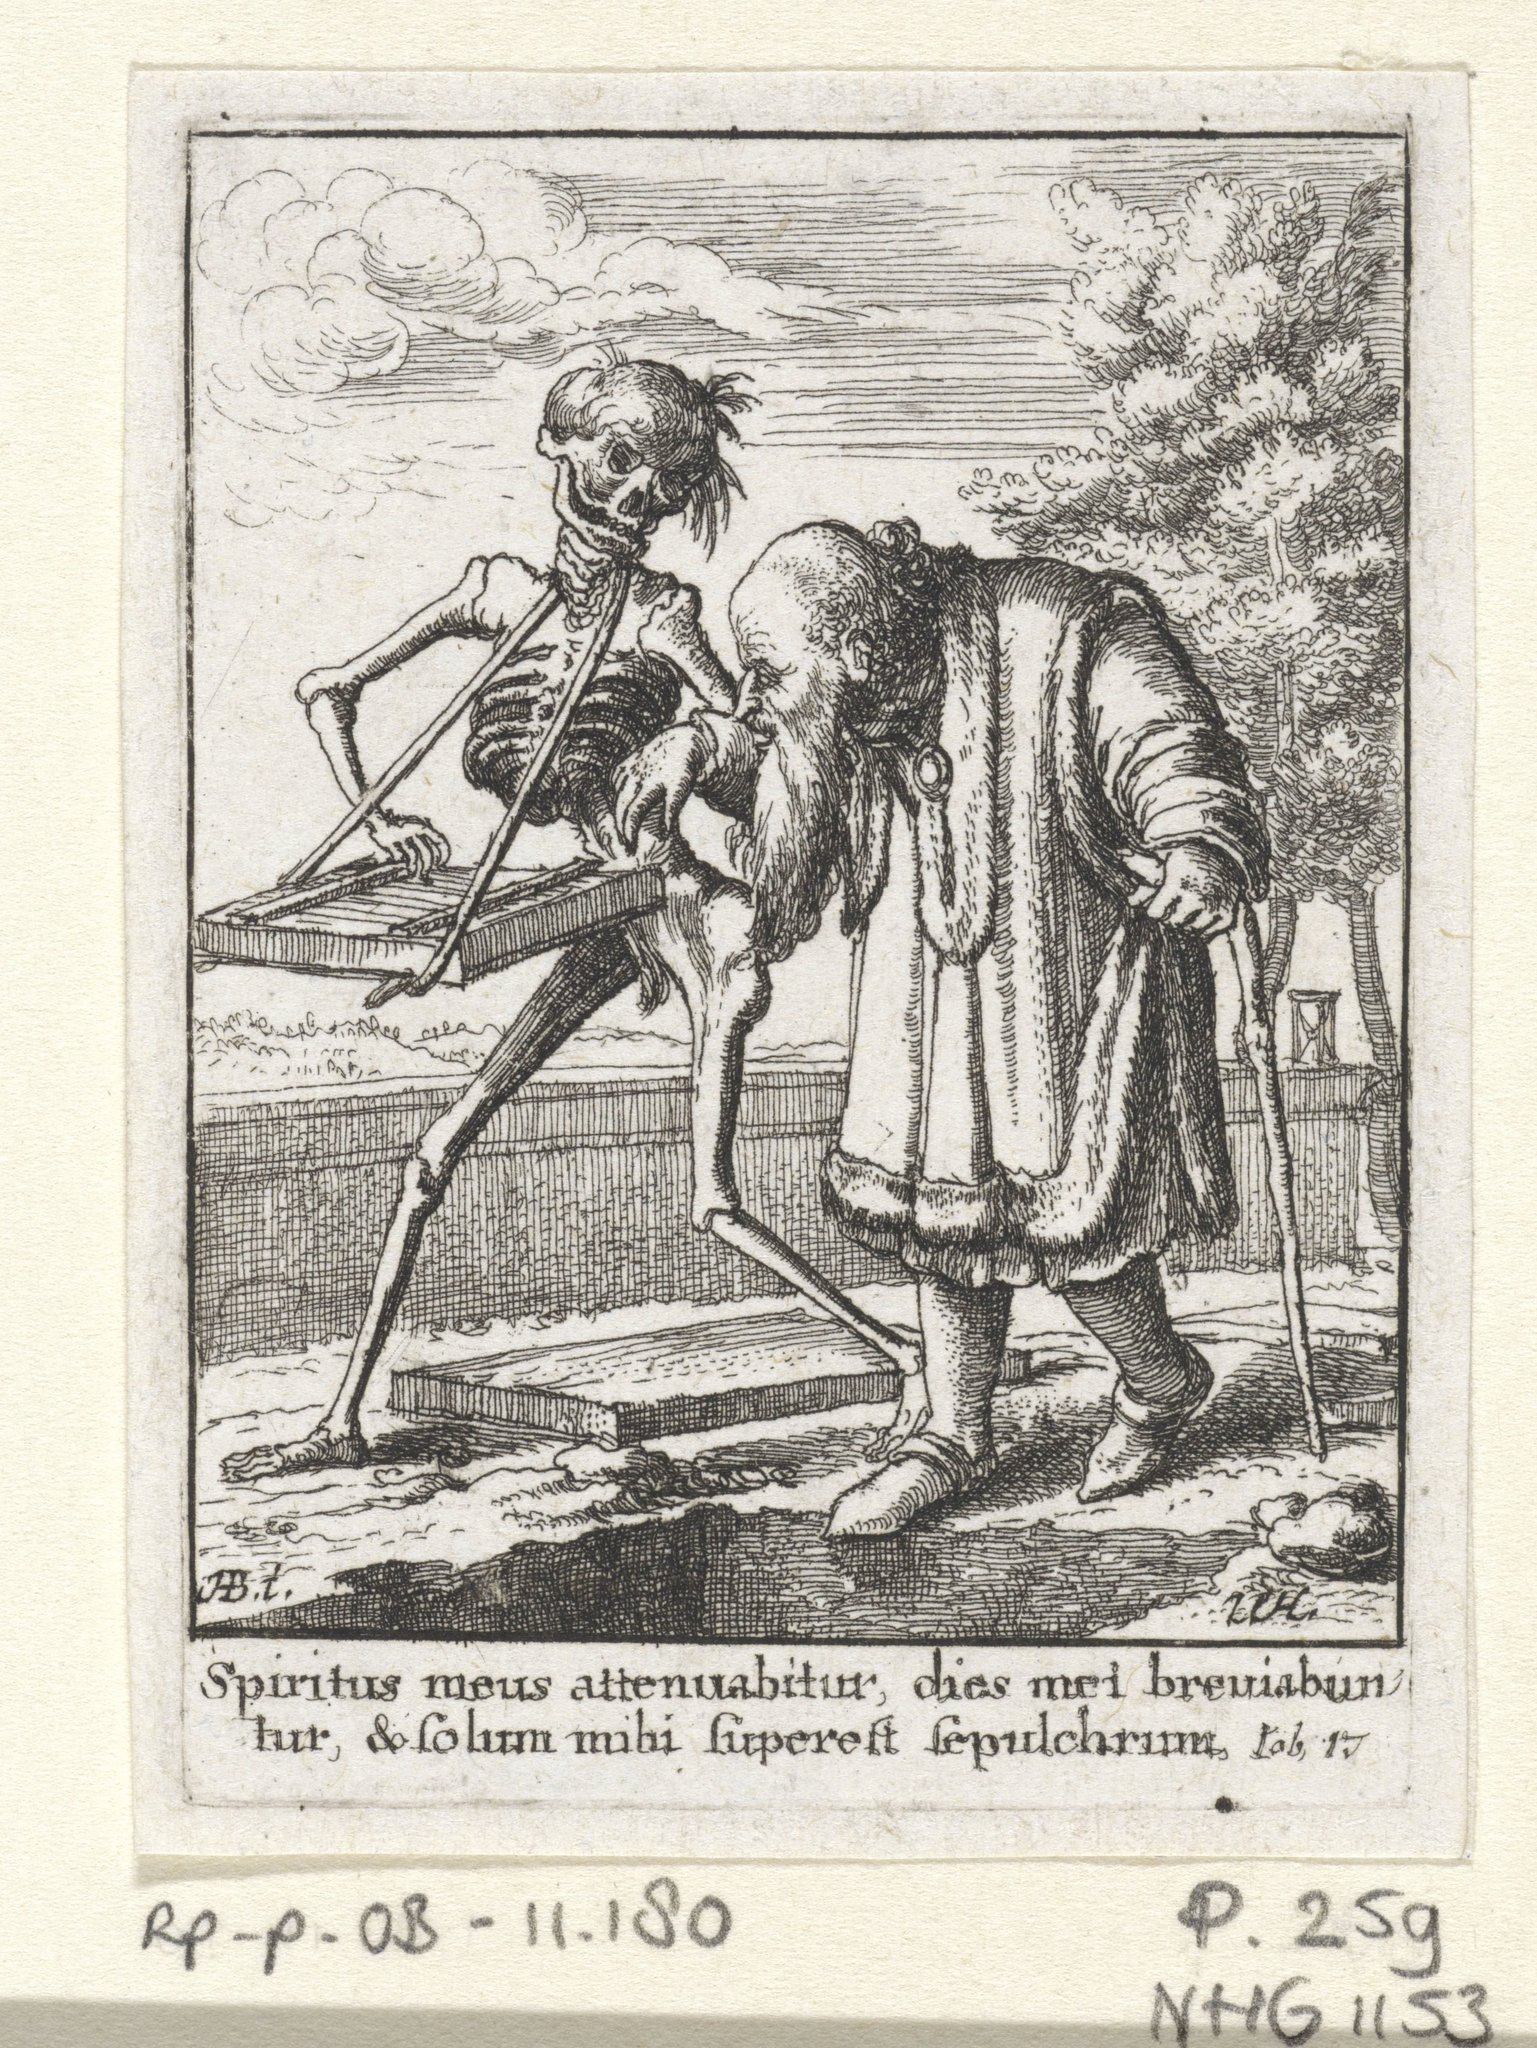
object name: book illustration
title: Dodendans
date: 1680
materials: paper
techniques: etching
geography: antwerp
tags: dance of death; death together with one or more human beings, old man, hourglass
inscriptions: collector's mark: Lugt 240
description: De Dood leidt een oude man naar zijn graf. Op een muurtje achter de oude man staat een zandloper.